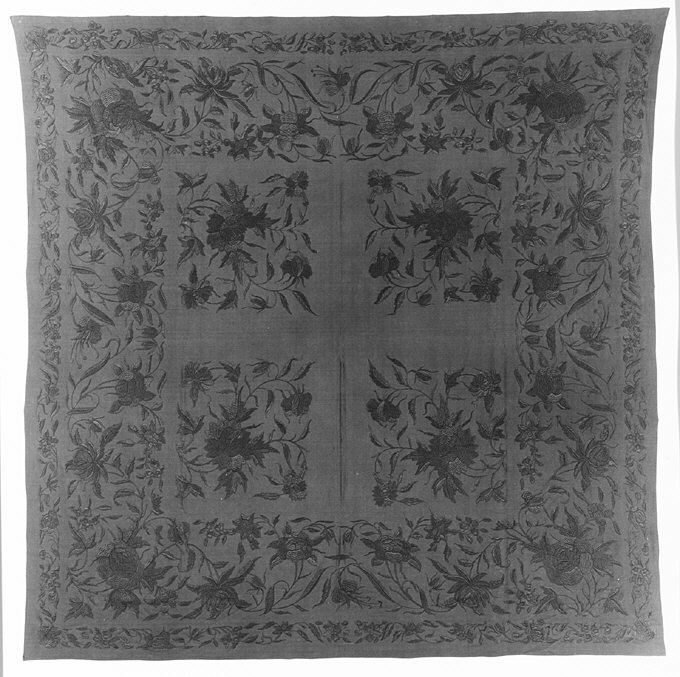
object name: shawl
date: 1834-1866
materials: silk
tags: flowers